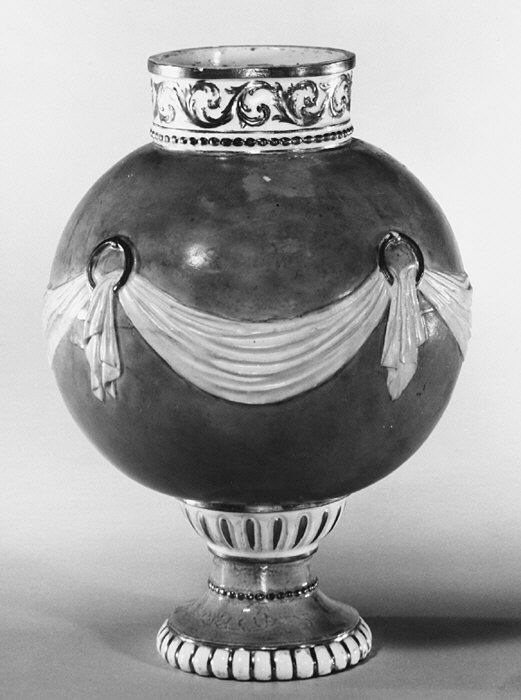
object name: vase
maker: höchst manufactory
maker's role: manufactory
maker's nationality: german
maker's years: 1746-1796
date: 1767-1800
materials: hard paste porcelain